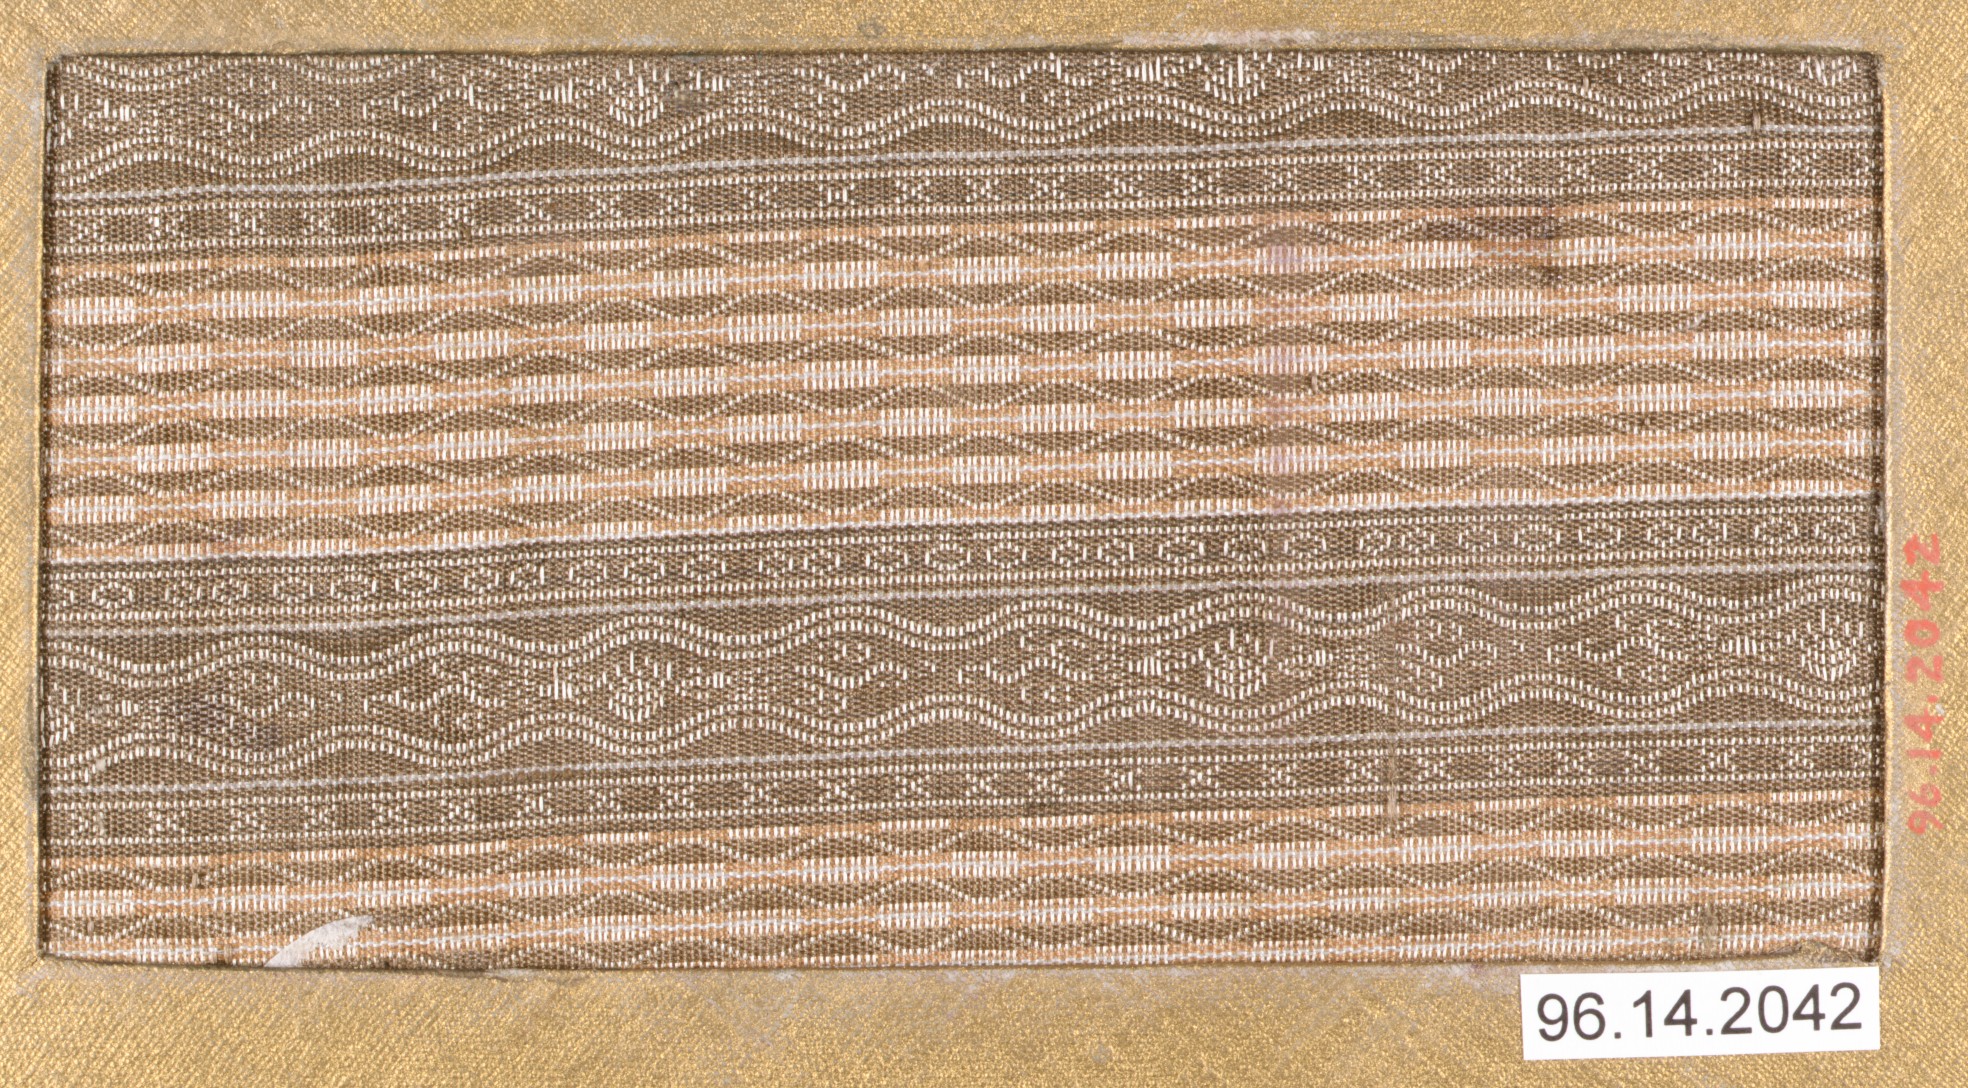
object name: piece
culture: japanese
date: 1701-1900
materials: silk